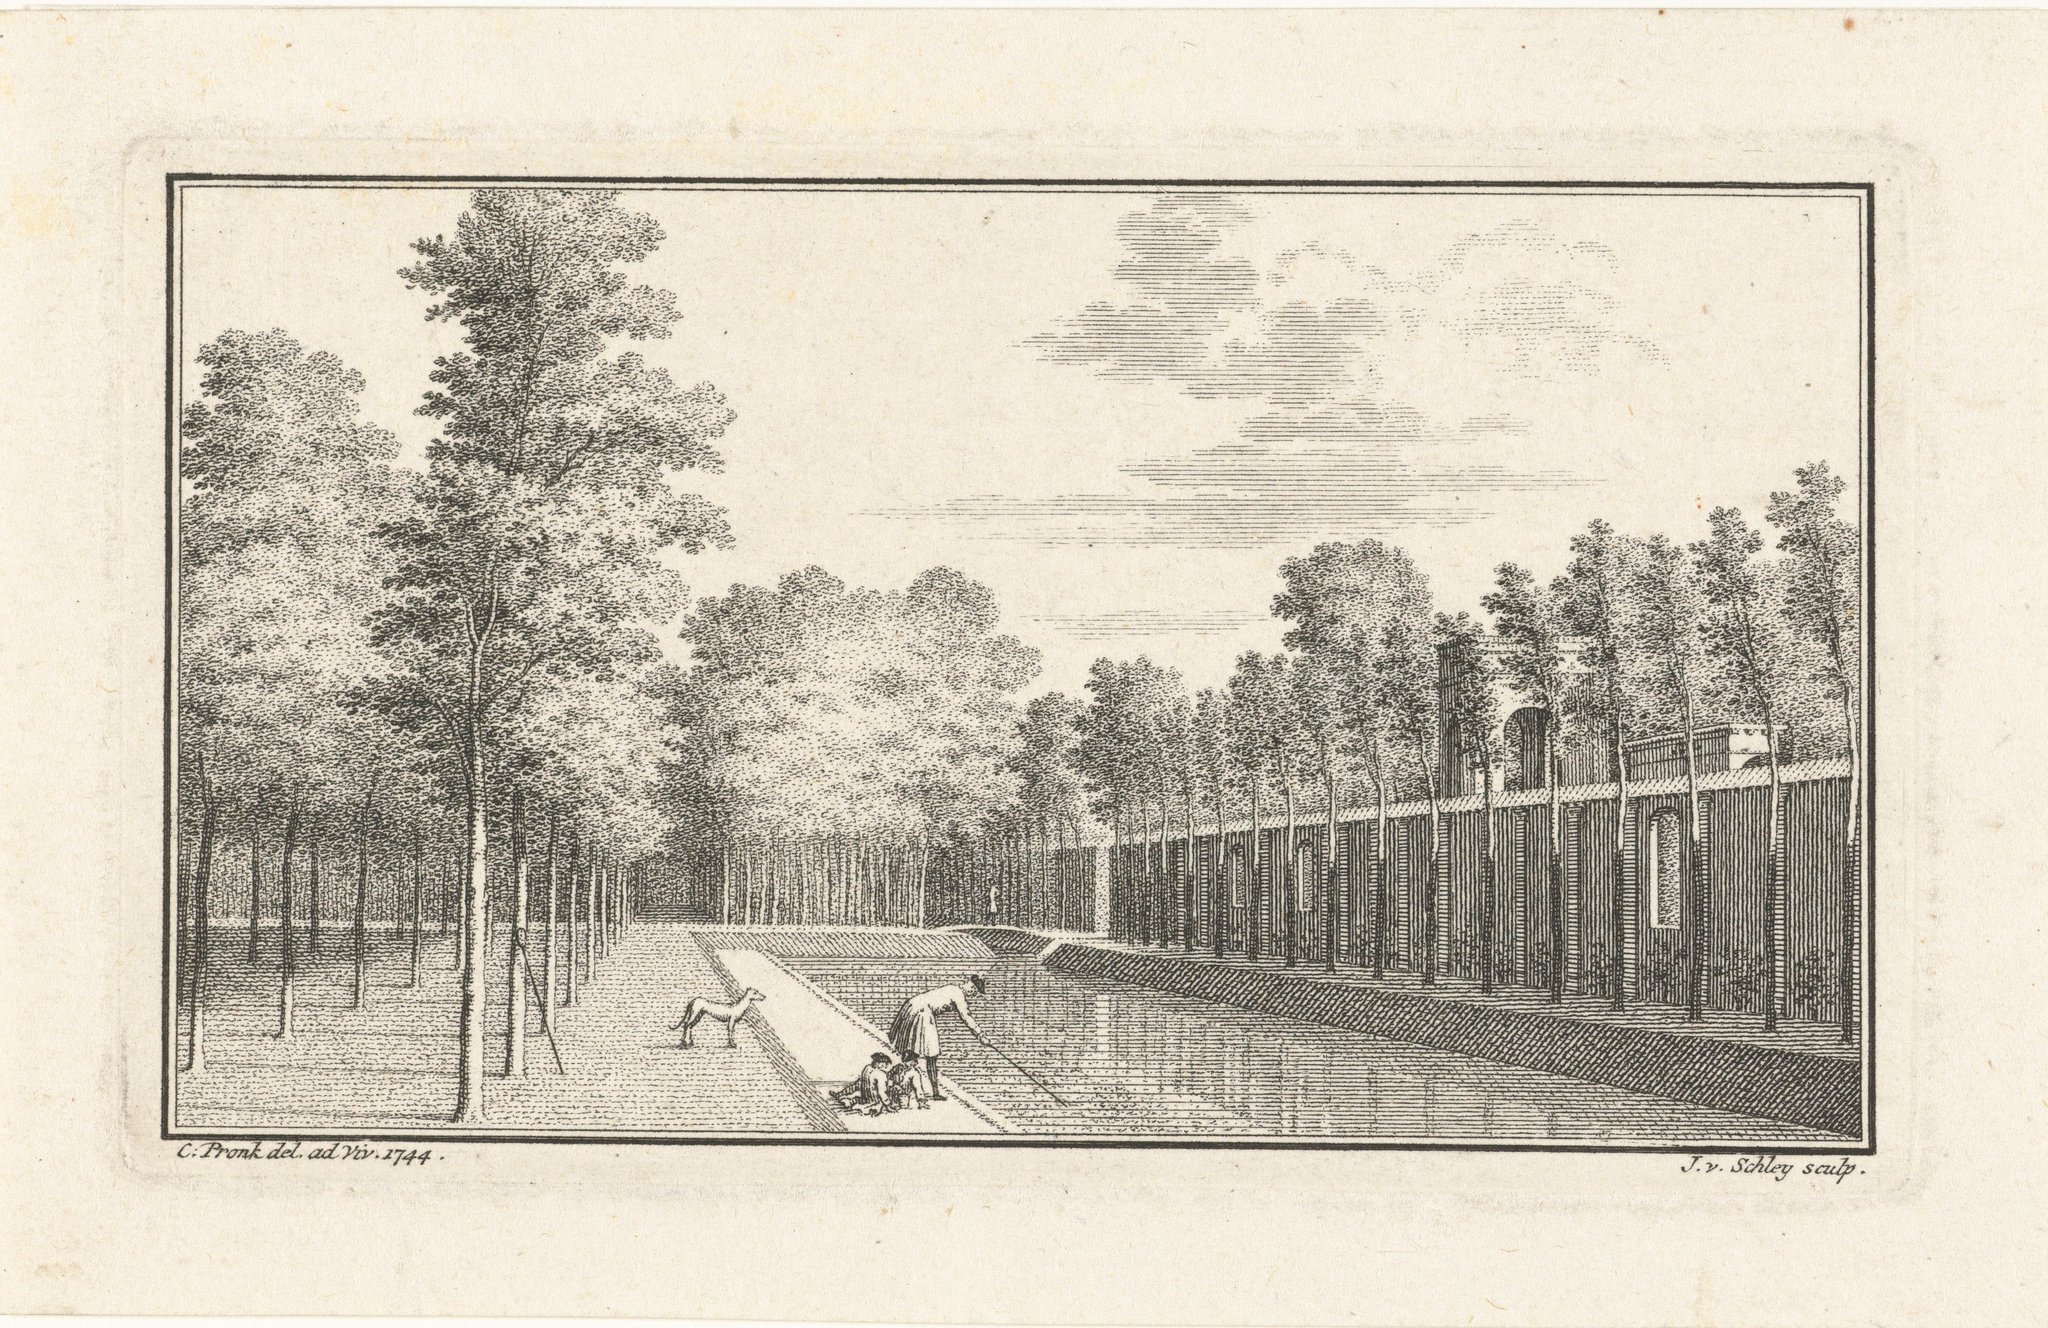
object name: print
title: Zorgvliet: de vijver ten oosten van de tuin achter het huis met Abraham Trembley en de zoontjes Bentinck die naar poliepen vissen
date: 1744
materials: paper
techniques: etching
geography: amsterdam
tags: fisherman, dog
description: De Zwitserse wetenschapper Abraham Trembley (1710-1784) probeert met een schepnet poliepen uit vijver bij huis Zorgvliet (Catshuis) te vissen. Achter hem zitten de twee zoontjes van Willem Bentinck (1704-1774), de bewoner van het huis, die hem assisteren bij zijn onderzoek naar zoetwaterpoliepen in de vijvers.